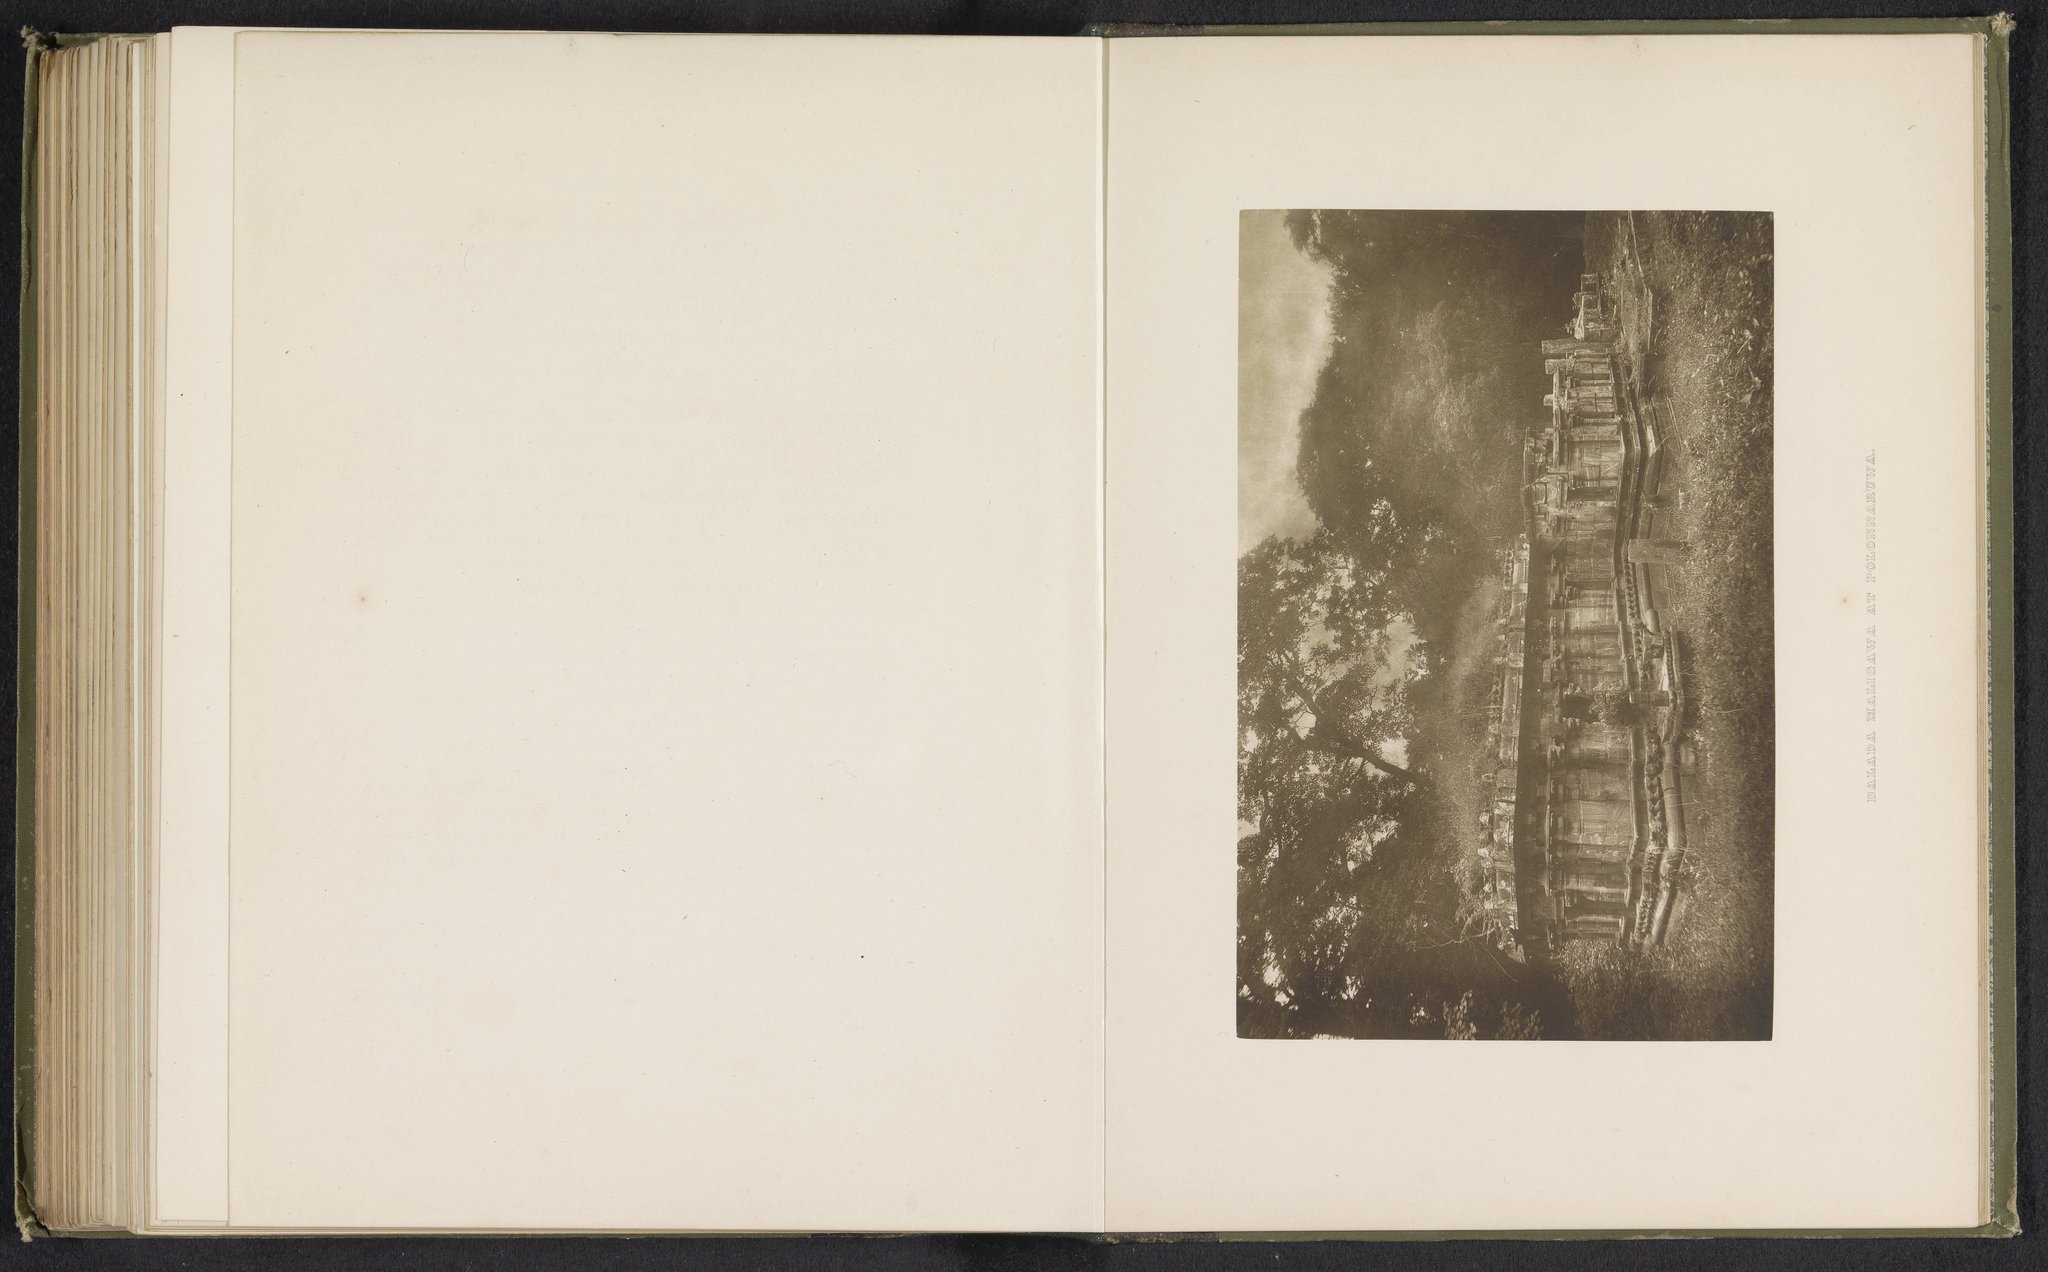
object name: photomechanical print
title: Ruins of the Dalada Maligawa temple at Polonnaruwa, Sri Lanka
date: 1896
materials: paper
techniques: woodburygravure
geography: polonnaruwa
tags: temple, shrine ~ hinduism, buddhism, jainism, ruin of a building ~ architecture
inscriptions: title: ‘DALADA MALIGAWA AT POLONNARUWA.’